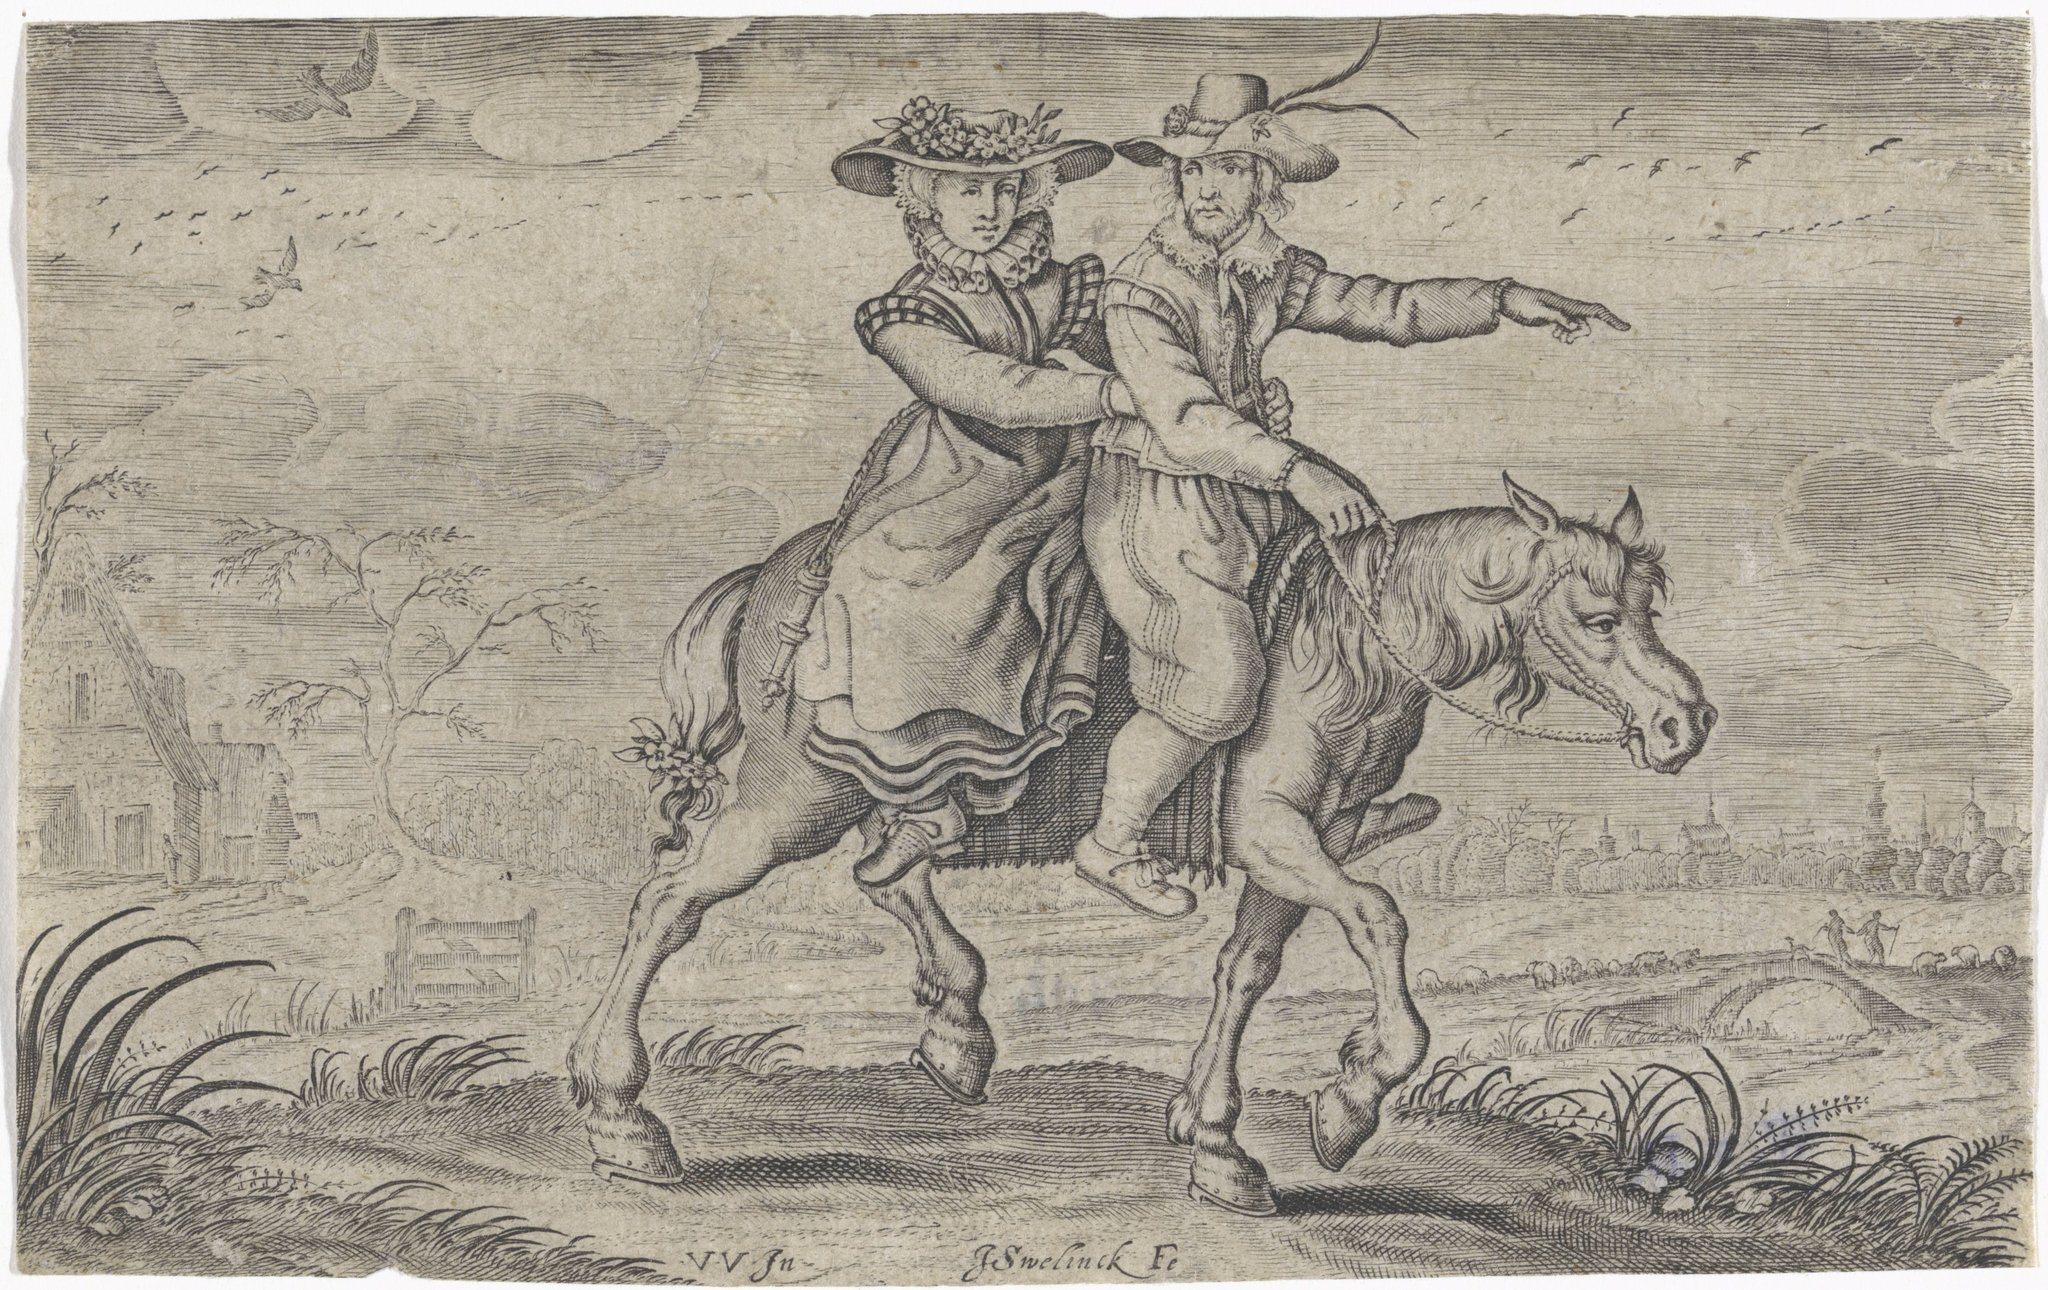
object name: print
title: Man en vrouw te paard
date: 1624-1645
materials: paper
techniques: engraving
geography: amsterdam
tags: riding a horse, ass, or mule; rider, horseman, horse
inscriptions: collector's mark: Lugt 2228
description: Een man en vrouw zitten samen op een paard, dat over een landweggetje loopt. De staart van het paard is met bloemen versierd. Op de achtergrond een stad. Onder en boven de prent versregels in het Nederlands.